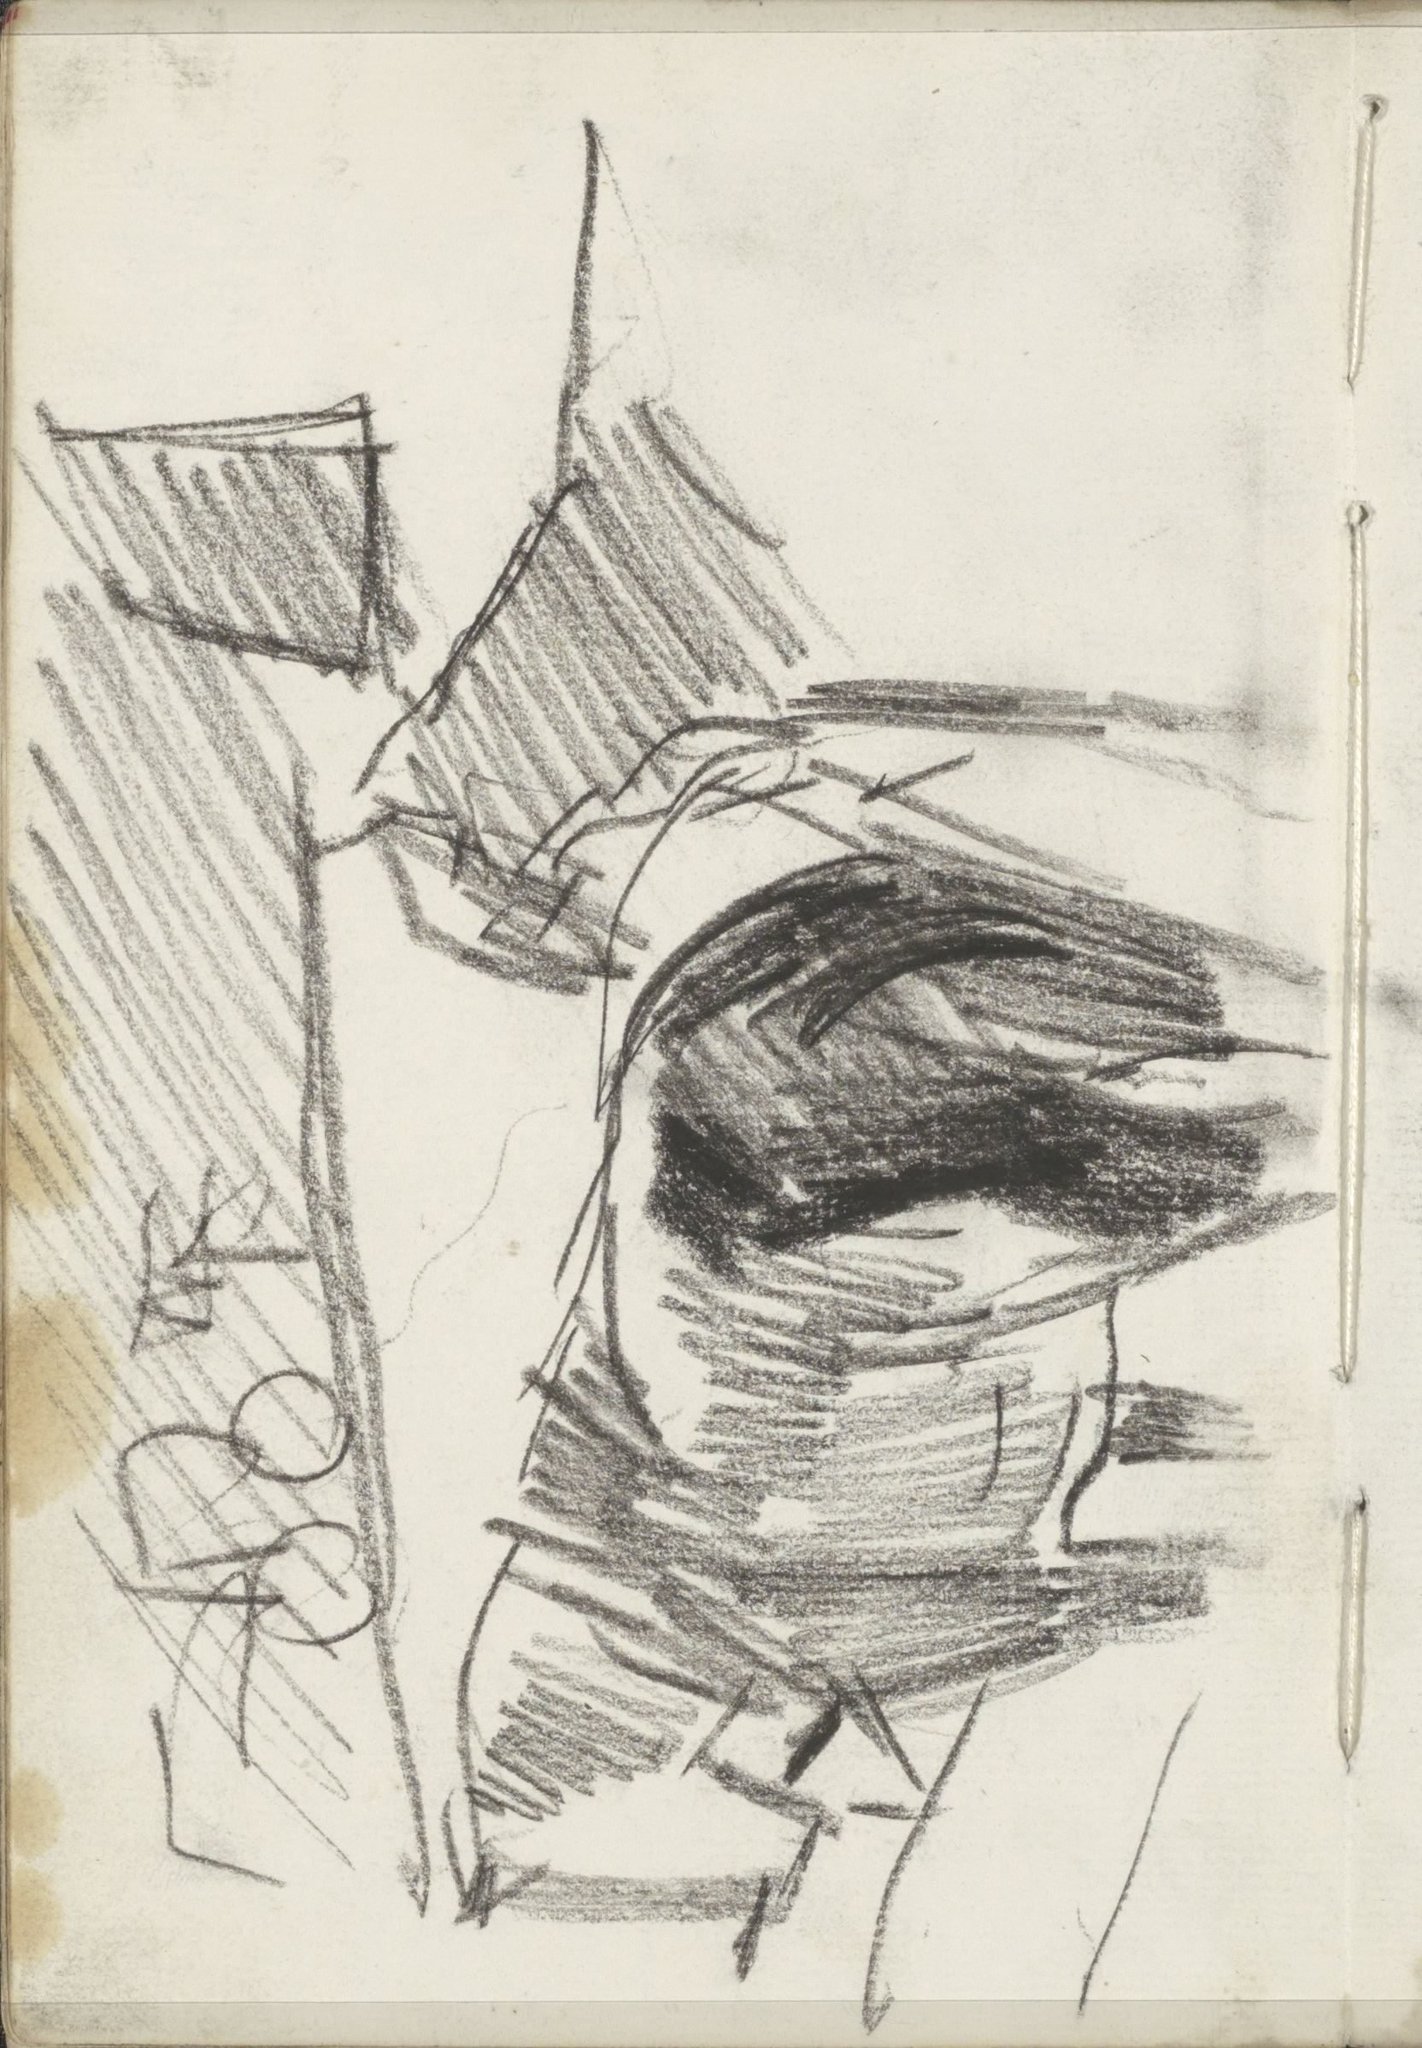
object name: sketchbook leaf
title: Twee paarden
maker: george hendrik breitner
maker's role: draughtsman, painter, print maker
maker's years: 1857-1923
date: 1886-1898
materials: chalk, paper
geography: amsterdam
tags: horse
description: Pagina 7 uit een schetsboek met 21 bladen.